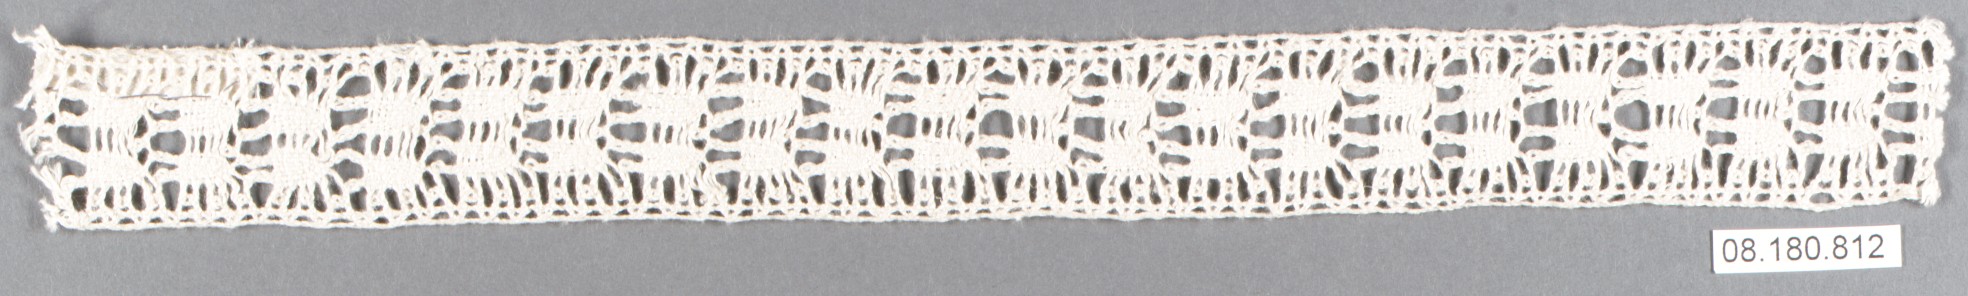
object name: insertion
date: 1801-1900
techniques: lace